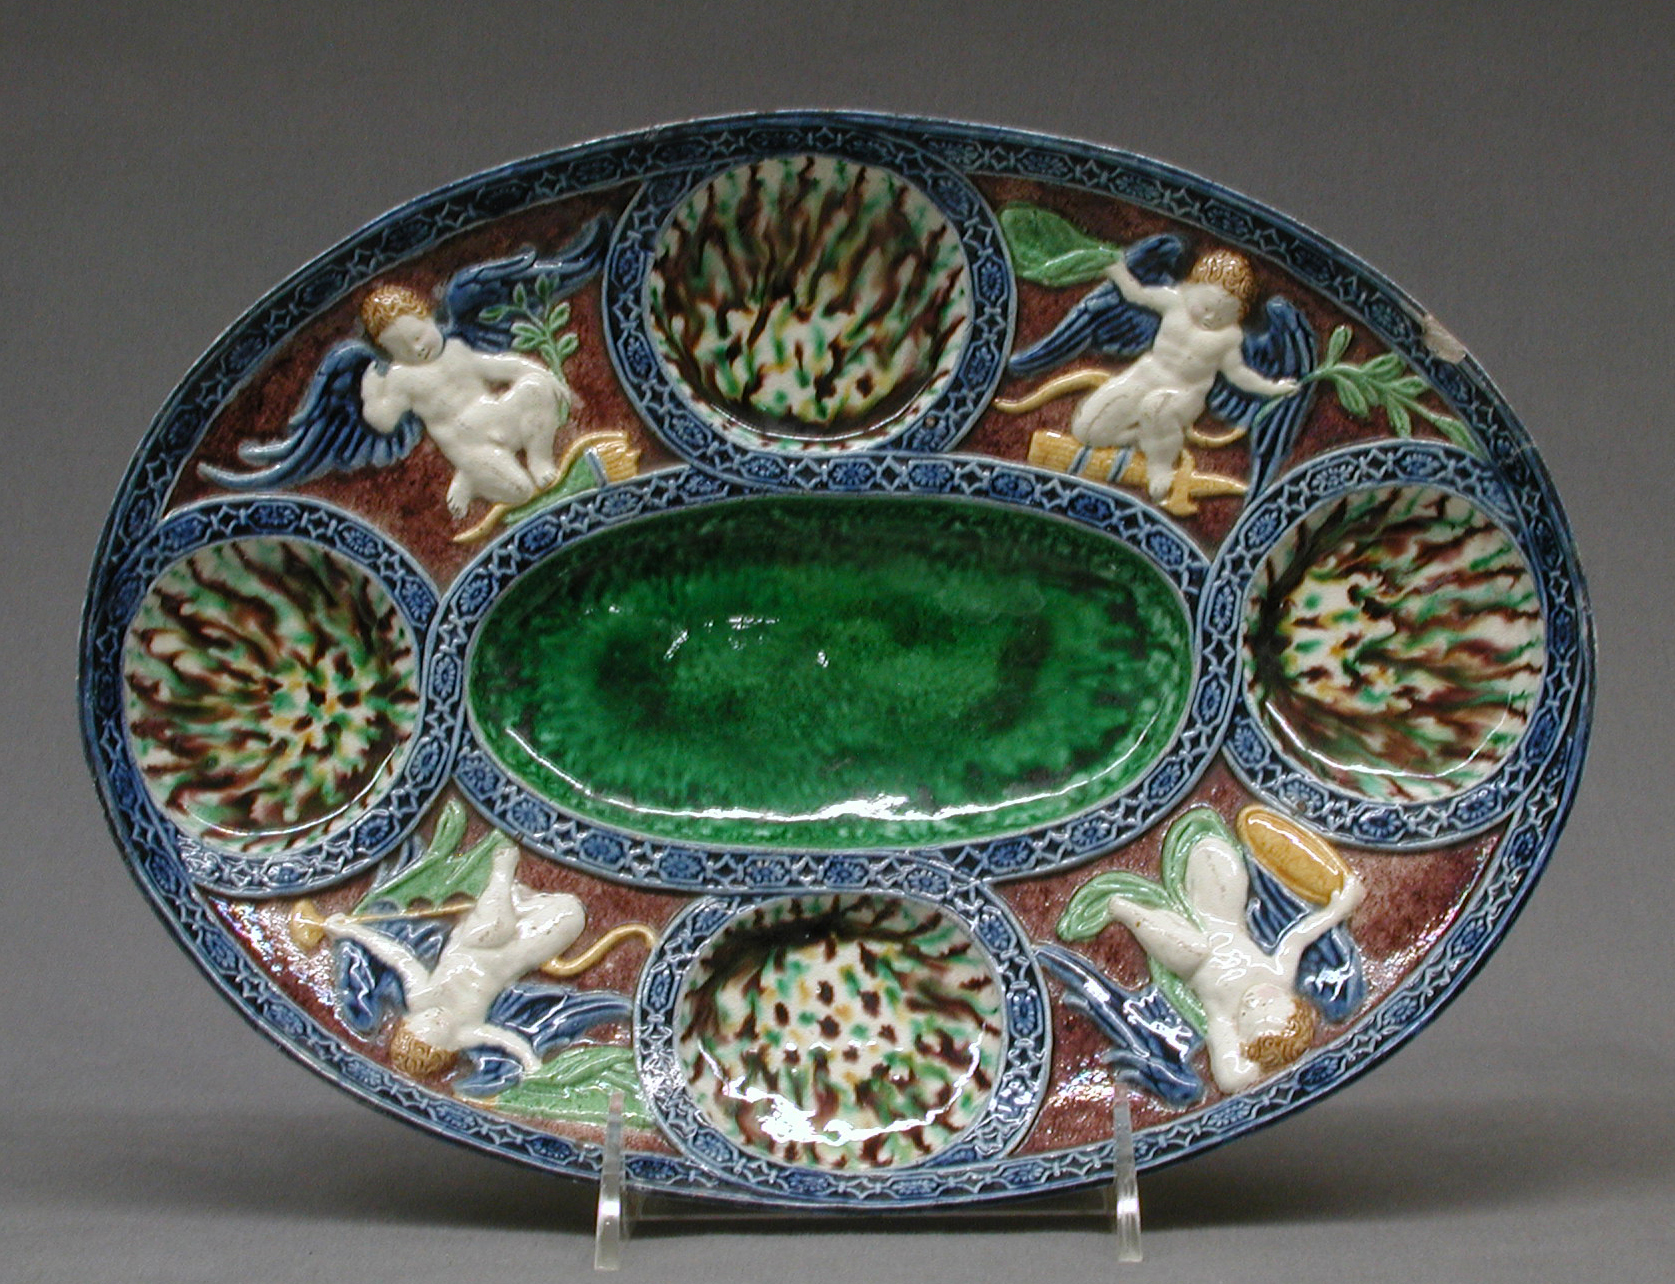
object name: dish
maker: bernard palissy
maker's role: maker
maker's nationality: french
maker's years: 1510-1590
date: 1801-1900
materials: earthenware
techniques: glazing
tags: cupid